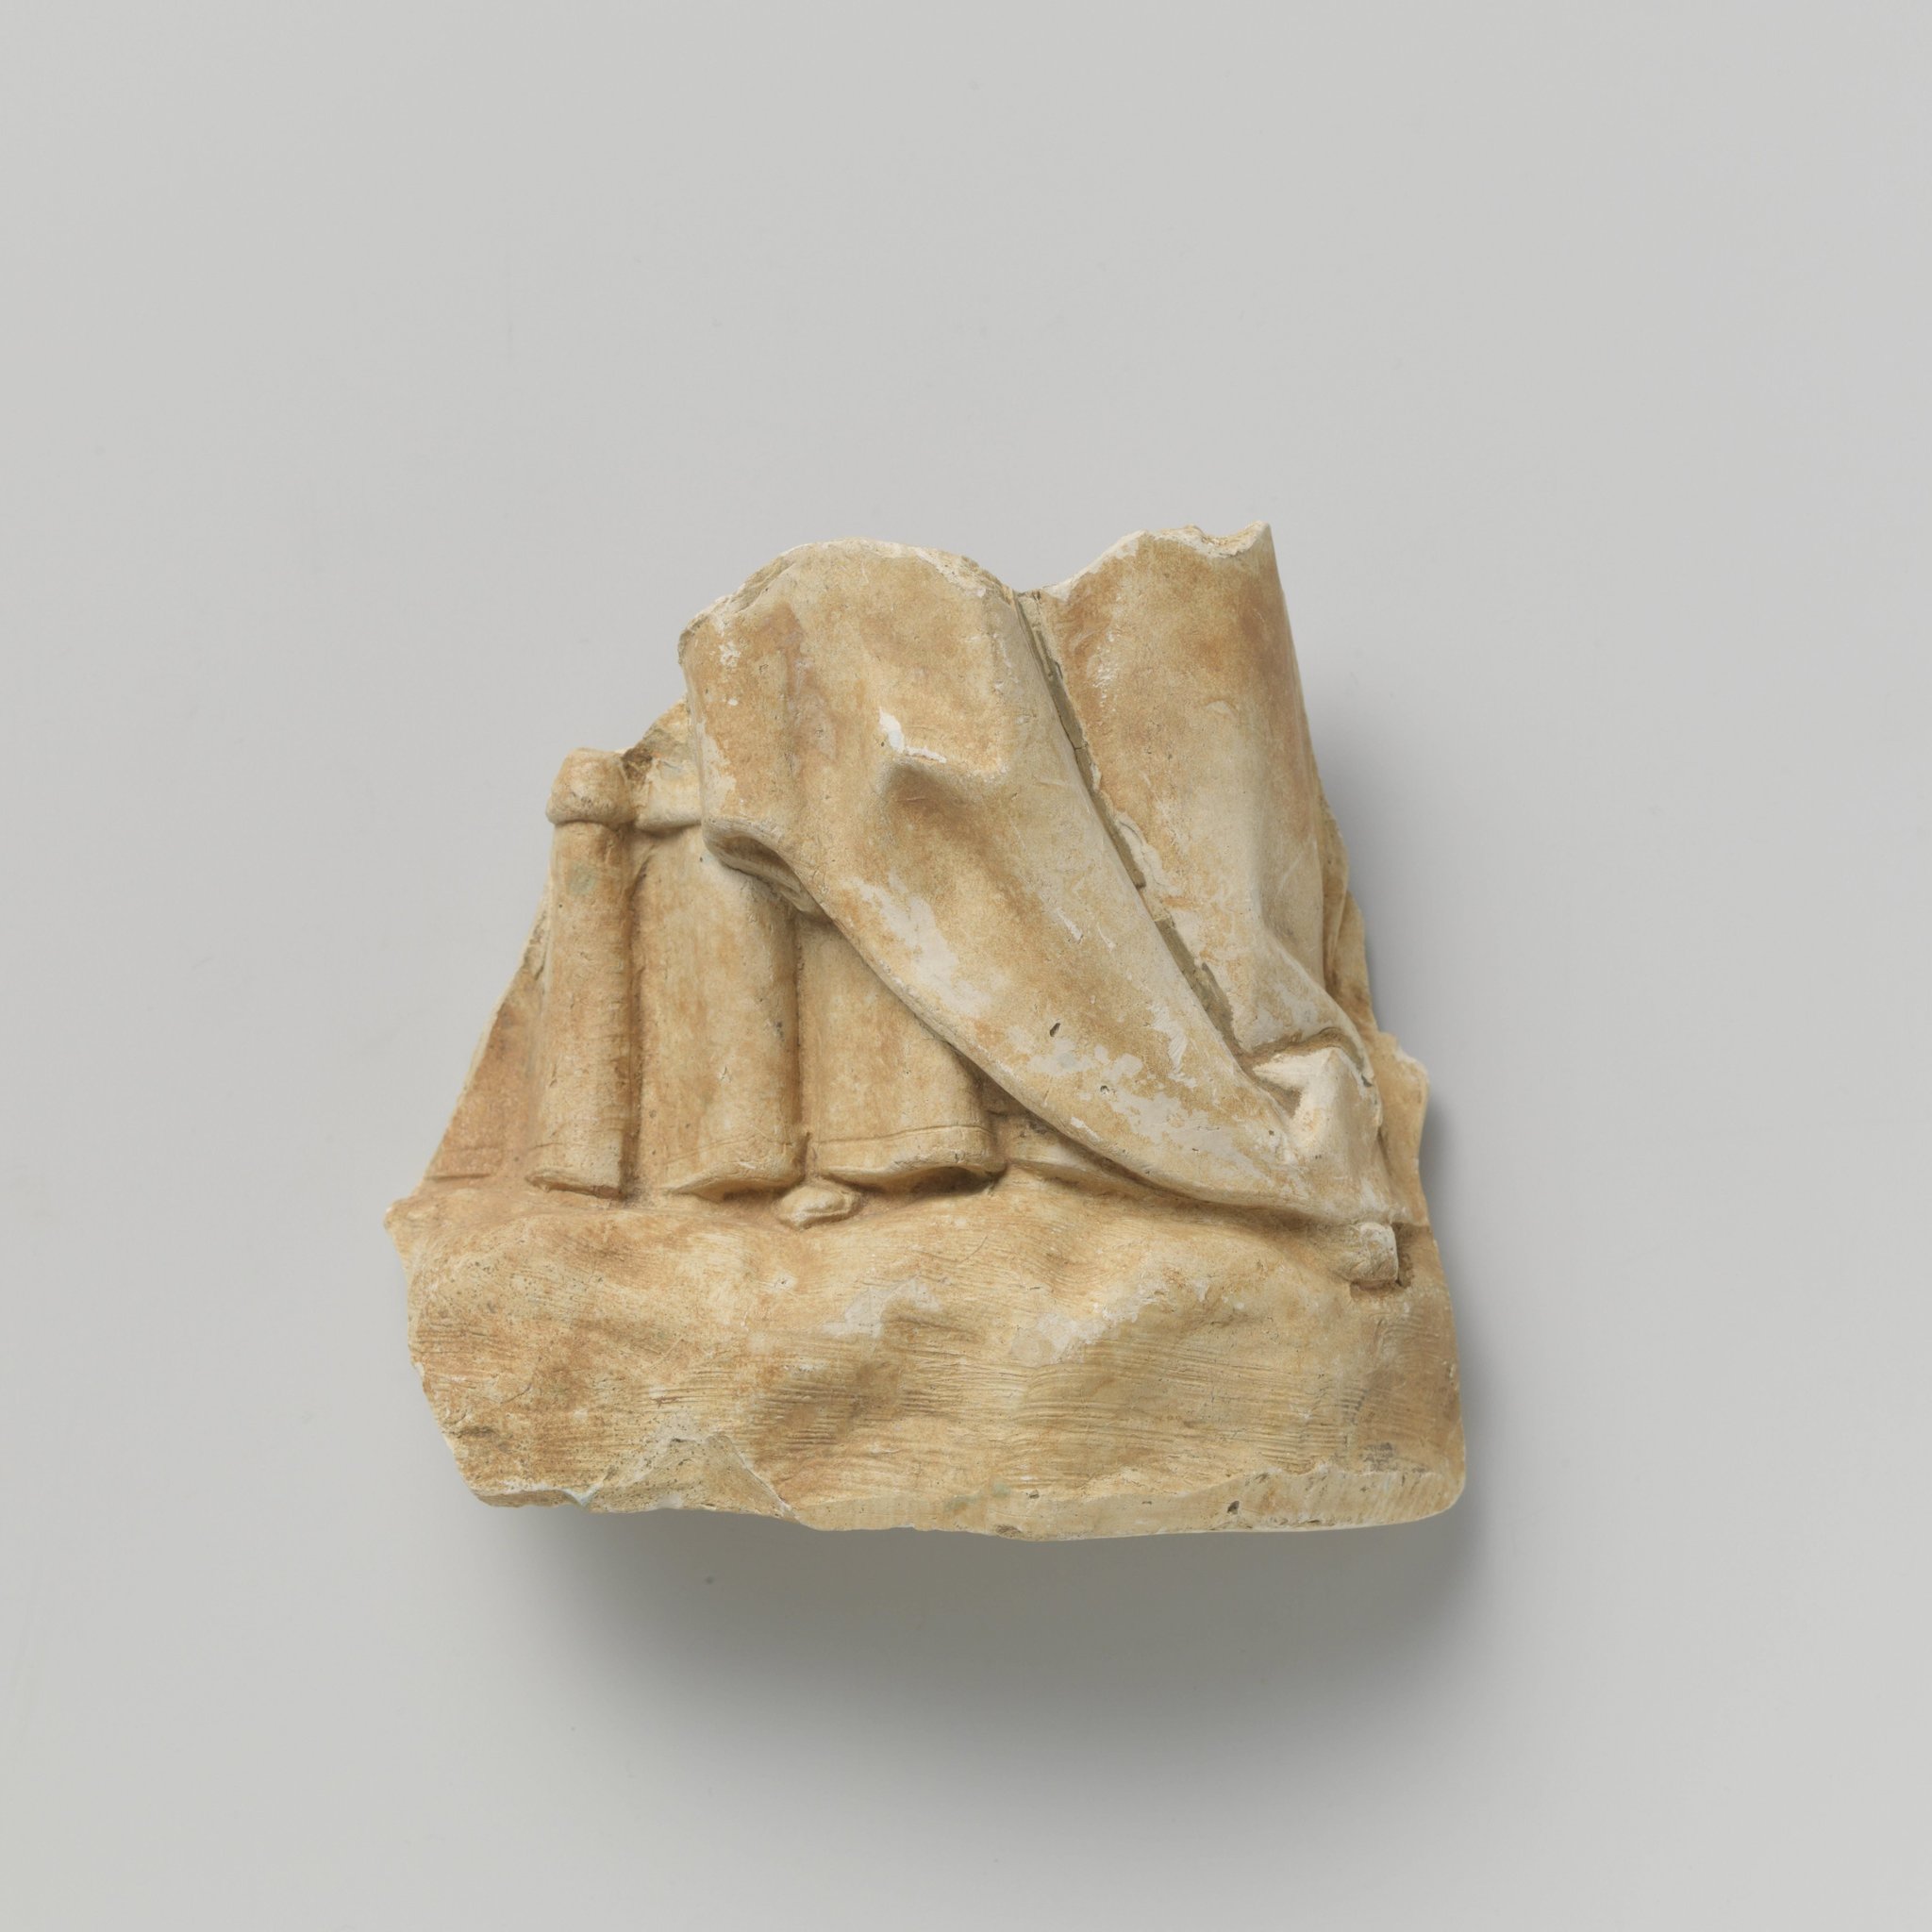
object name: sculpture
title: Standing Saint, Fragment of the Lower Section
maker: Anonymous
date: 1425-1550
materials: clay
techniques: modeling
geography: utrecht